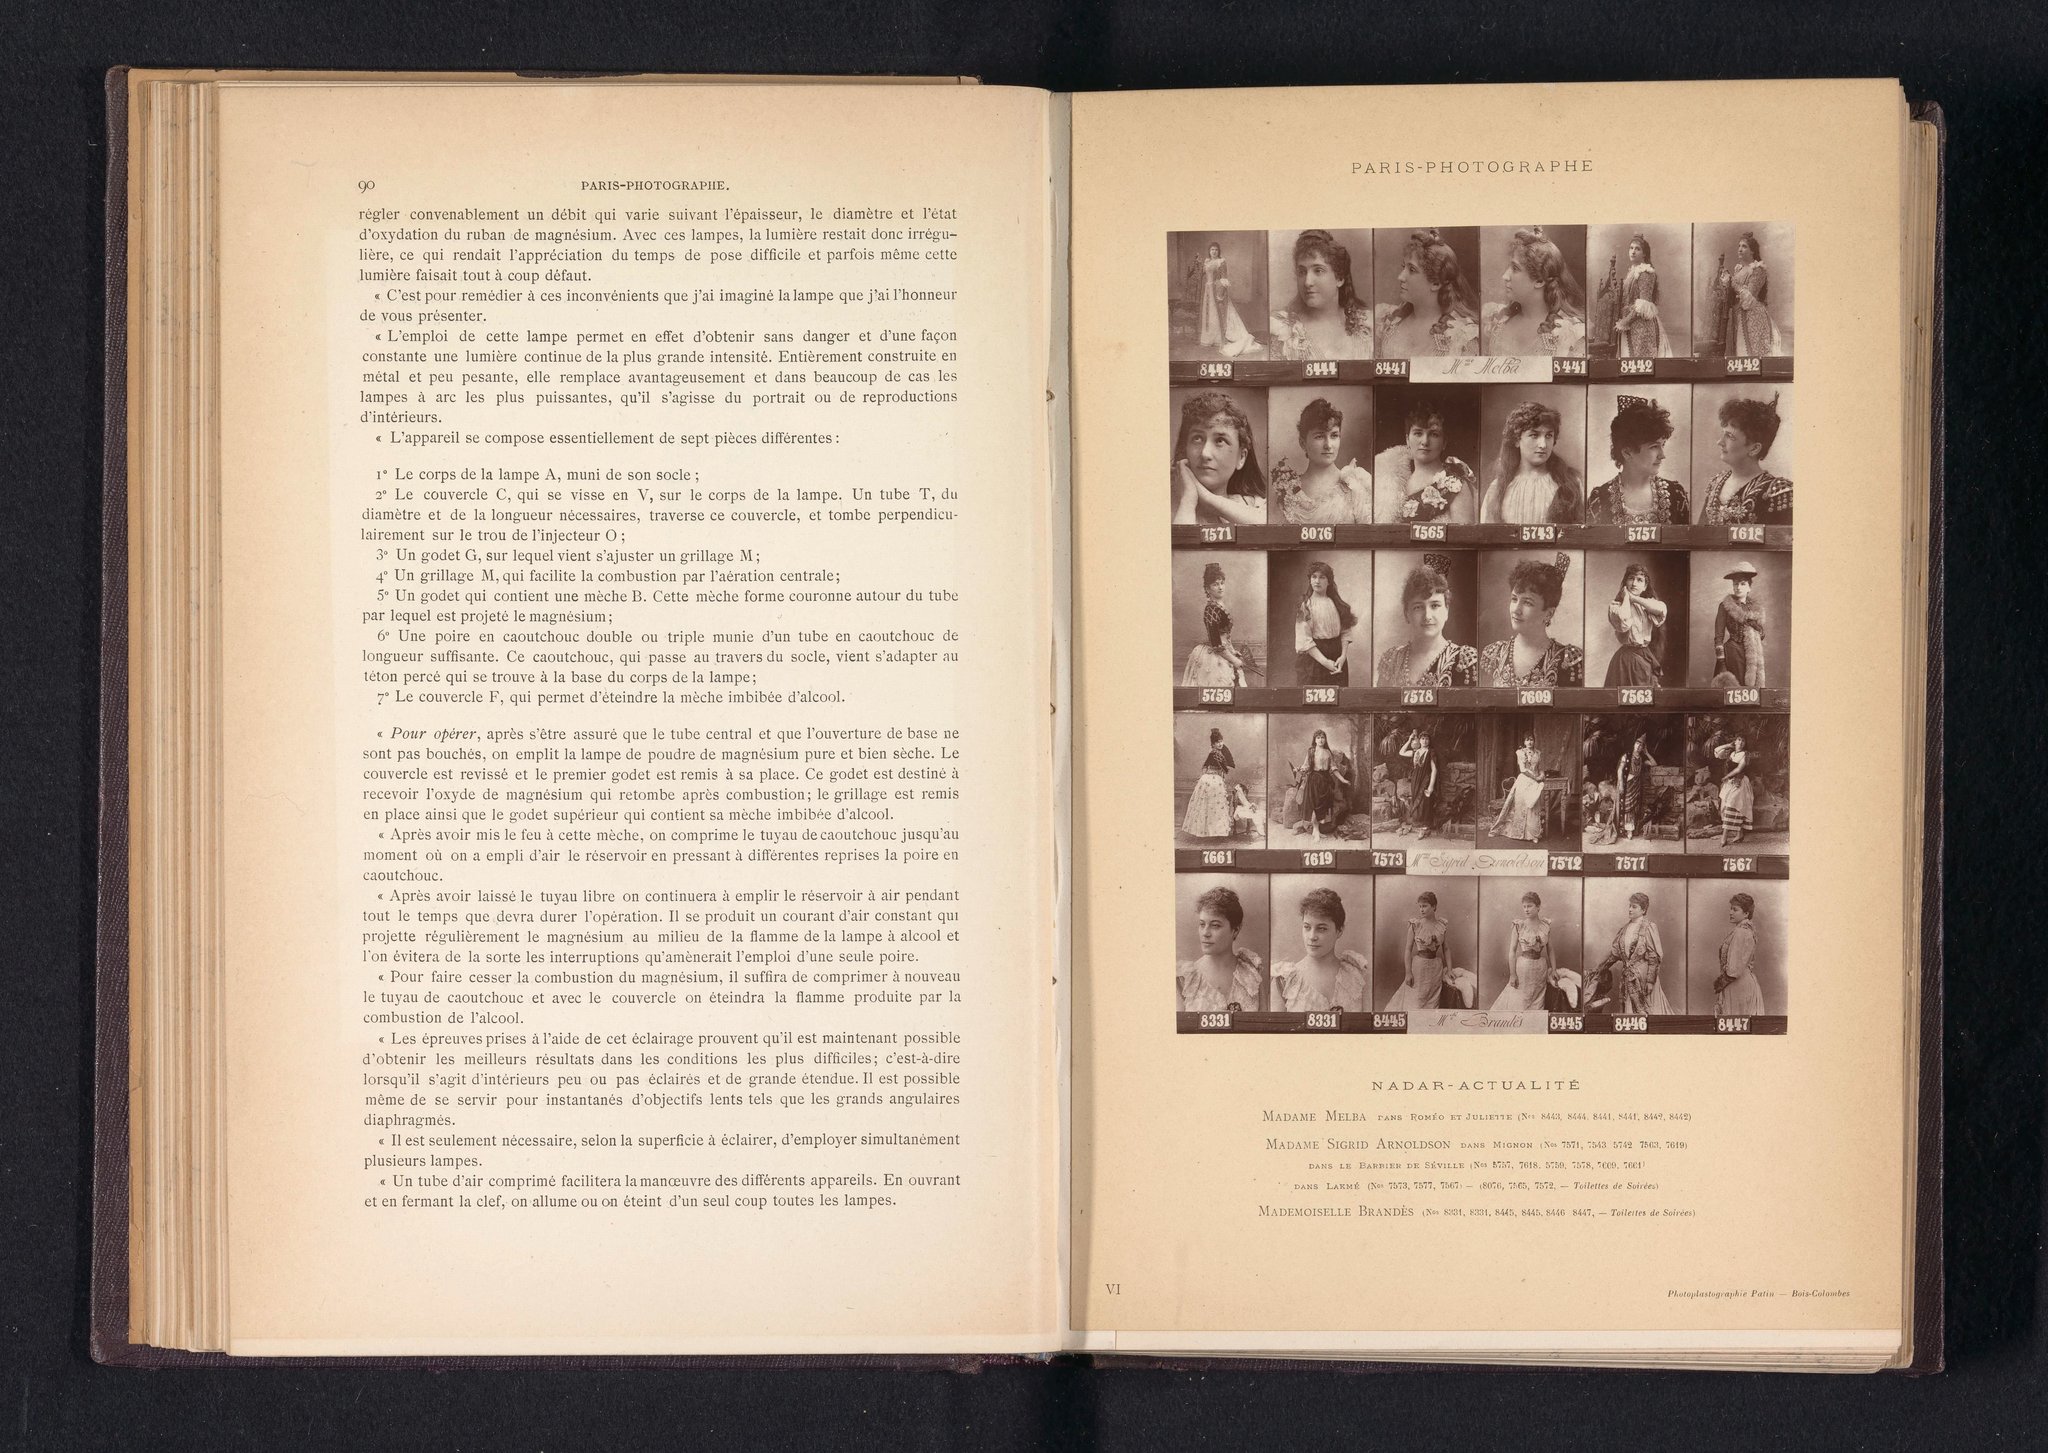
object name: photomechanical print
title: Dertig portretten van Nellie Melba, Sigrid Arnoldson en Marthe Brandès in verschillende theaterrollen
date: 1881-1891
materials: paper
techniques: woodburytype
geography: paris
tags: stage costume, portrait of opera-singer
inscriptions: number: ‘8443 (...) 8447’, inscription: ‘Madame Melba Dans Roméo et Juliette (...) Madame Sigrid Arnoldson Dan Mignon (...) Dans le Barbier de Séville (...) Dans Lakmé (...) Mademoiselle Brandès (...)’